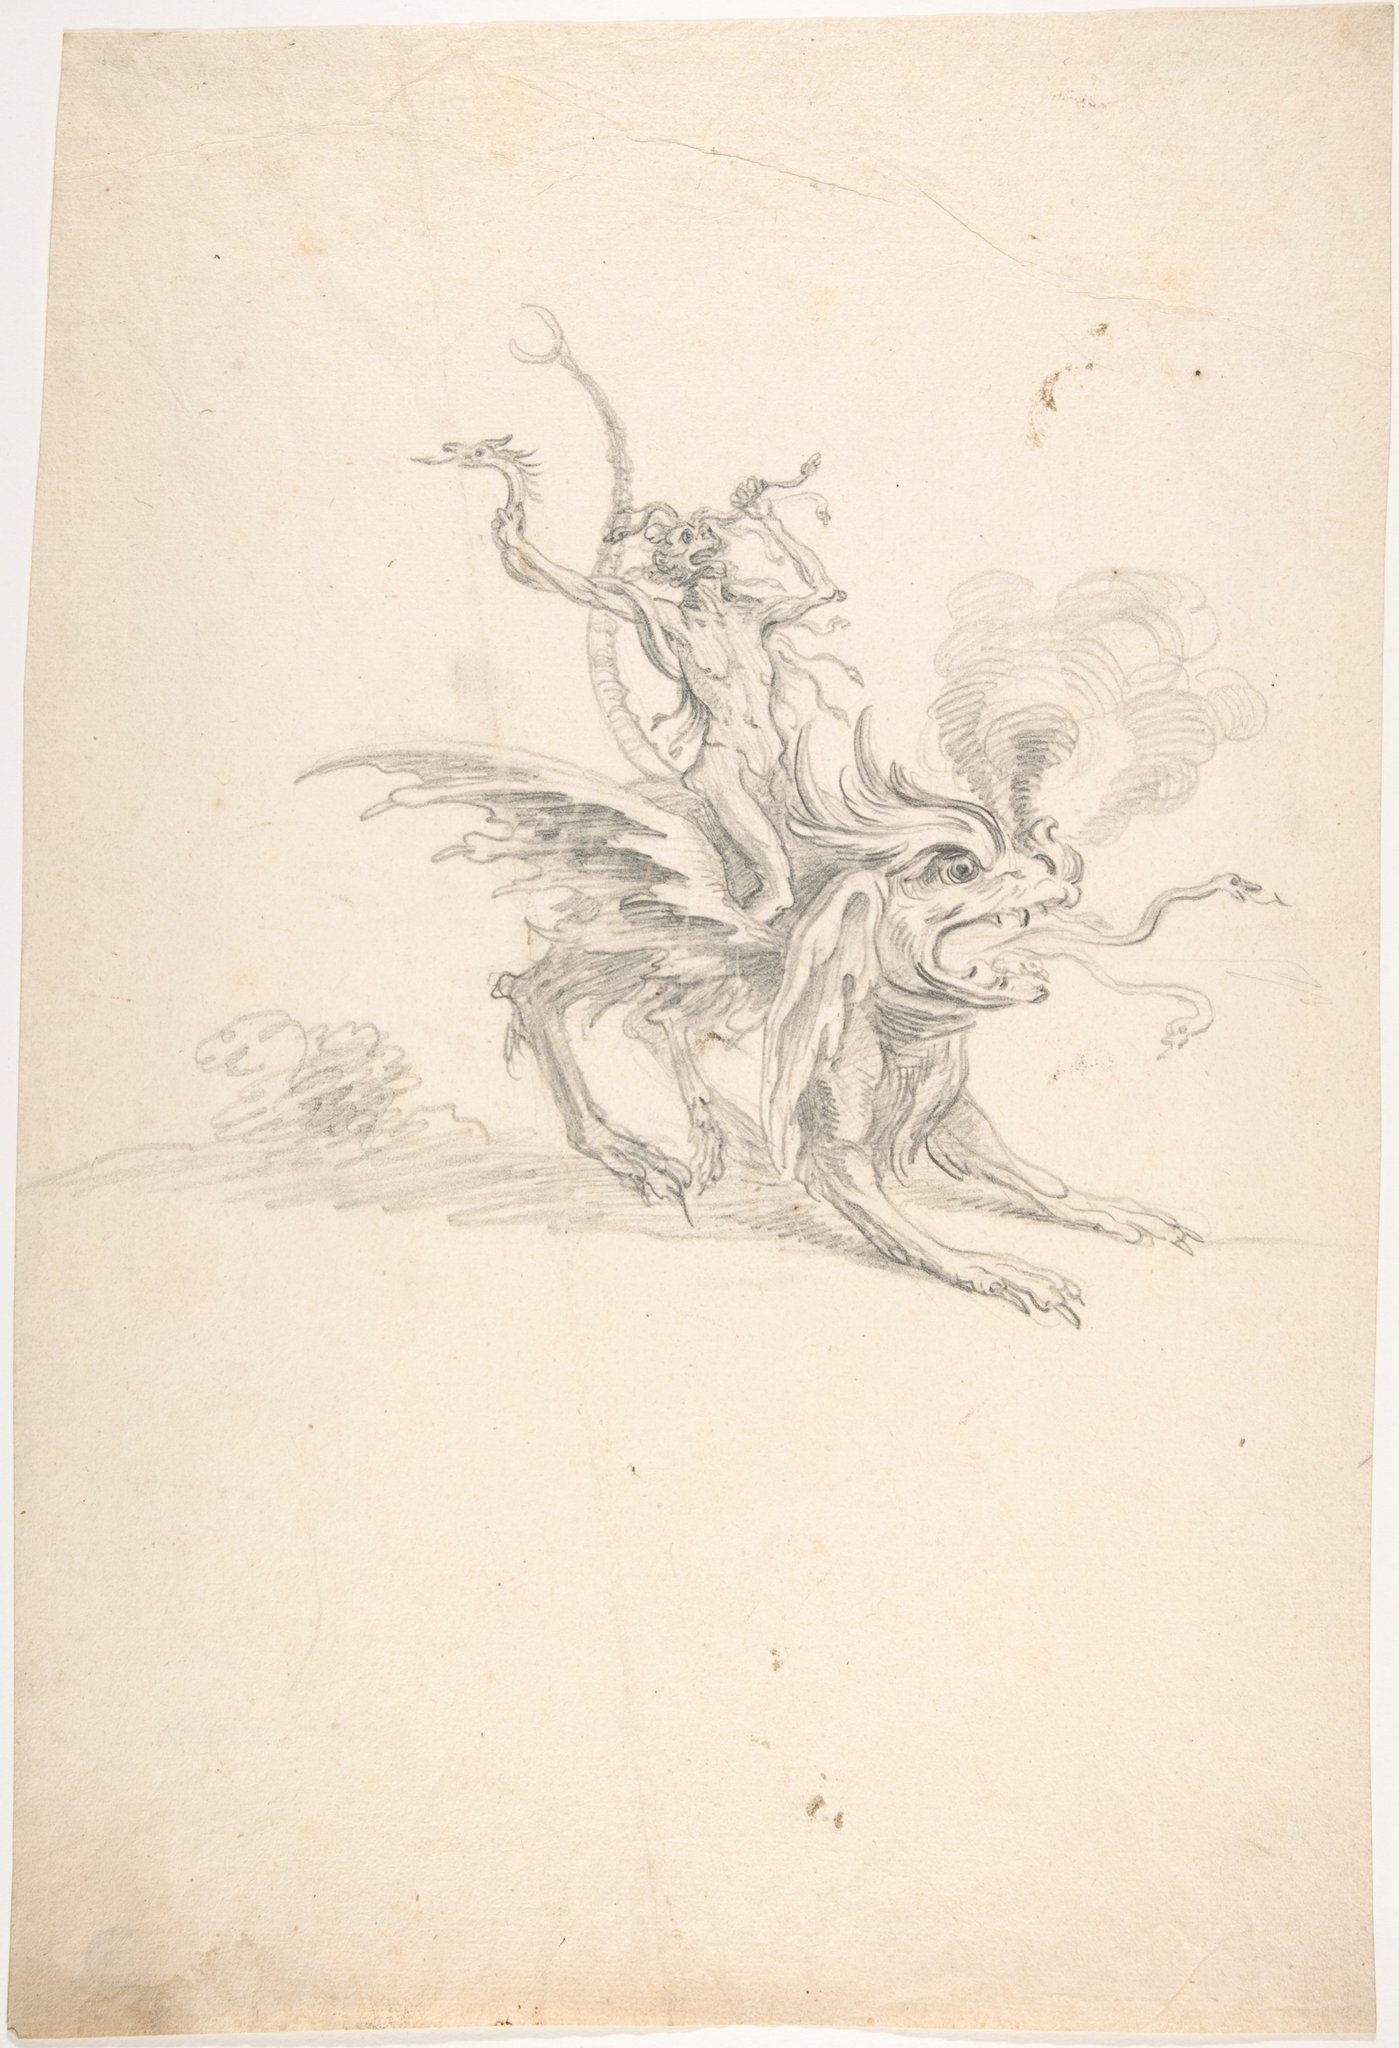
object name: drawing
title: A Fury Riding on a Monster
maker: anonymous, dutch, 18th century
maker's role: artist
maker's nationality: dutch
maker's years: 1700-1800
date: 1701-1800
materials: chalk, graphite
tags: mythical creatures,monsters